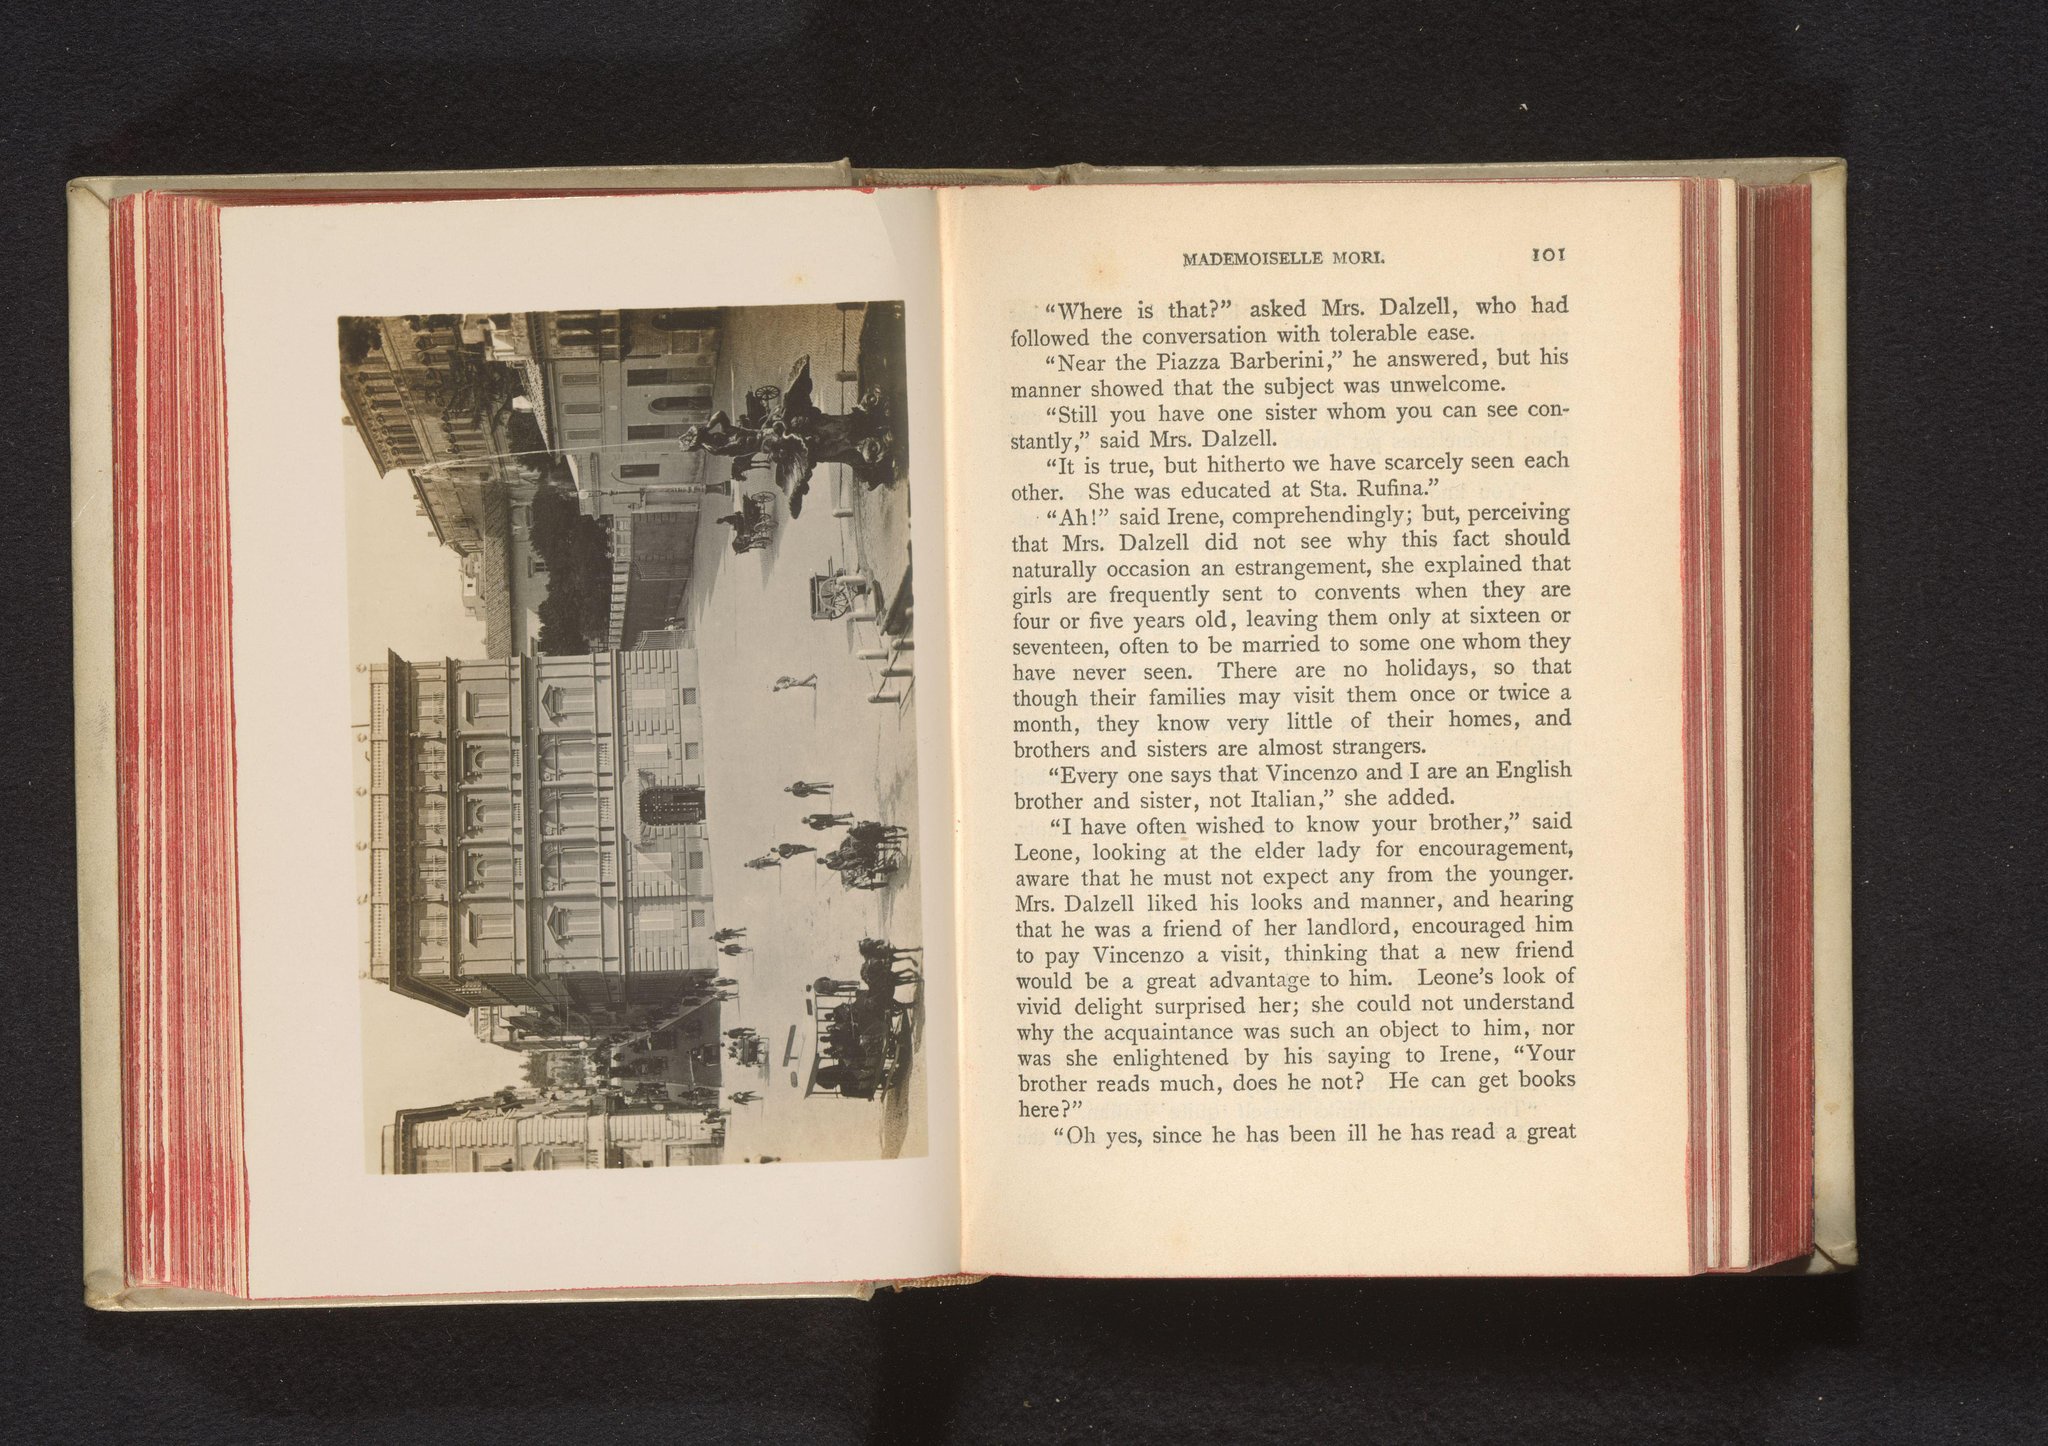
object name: page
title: Gezicht op het Piazza Barberini te Rome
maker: Anonymous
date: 1852-1862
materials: photographic support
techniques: gelatin silver print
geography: piazza barberini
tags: square, place, circus, etc., façade (of house or building)